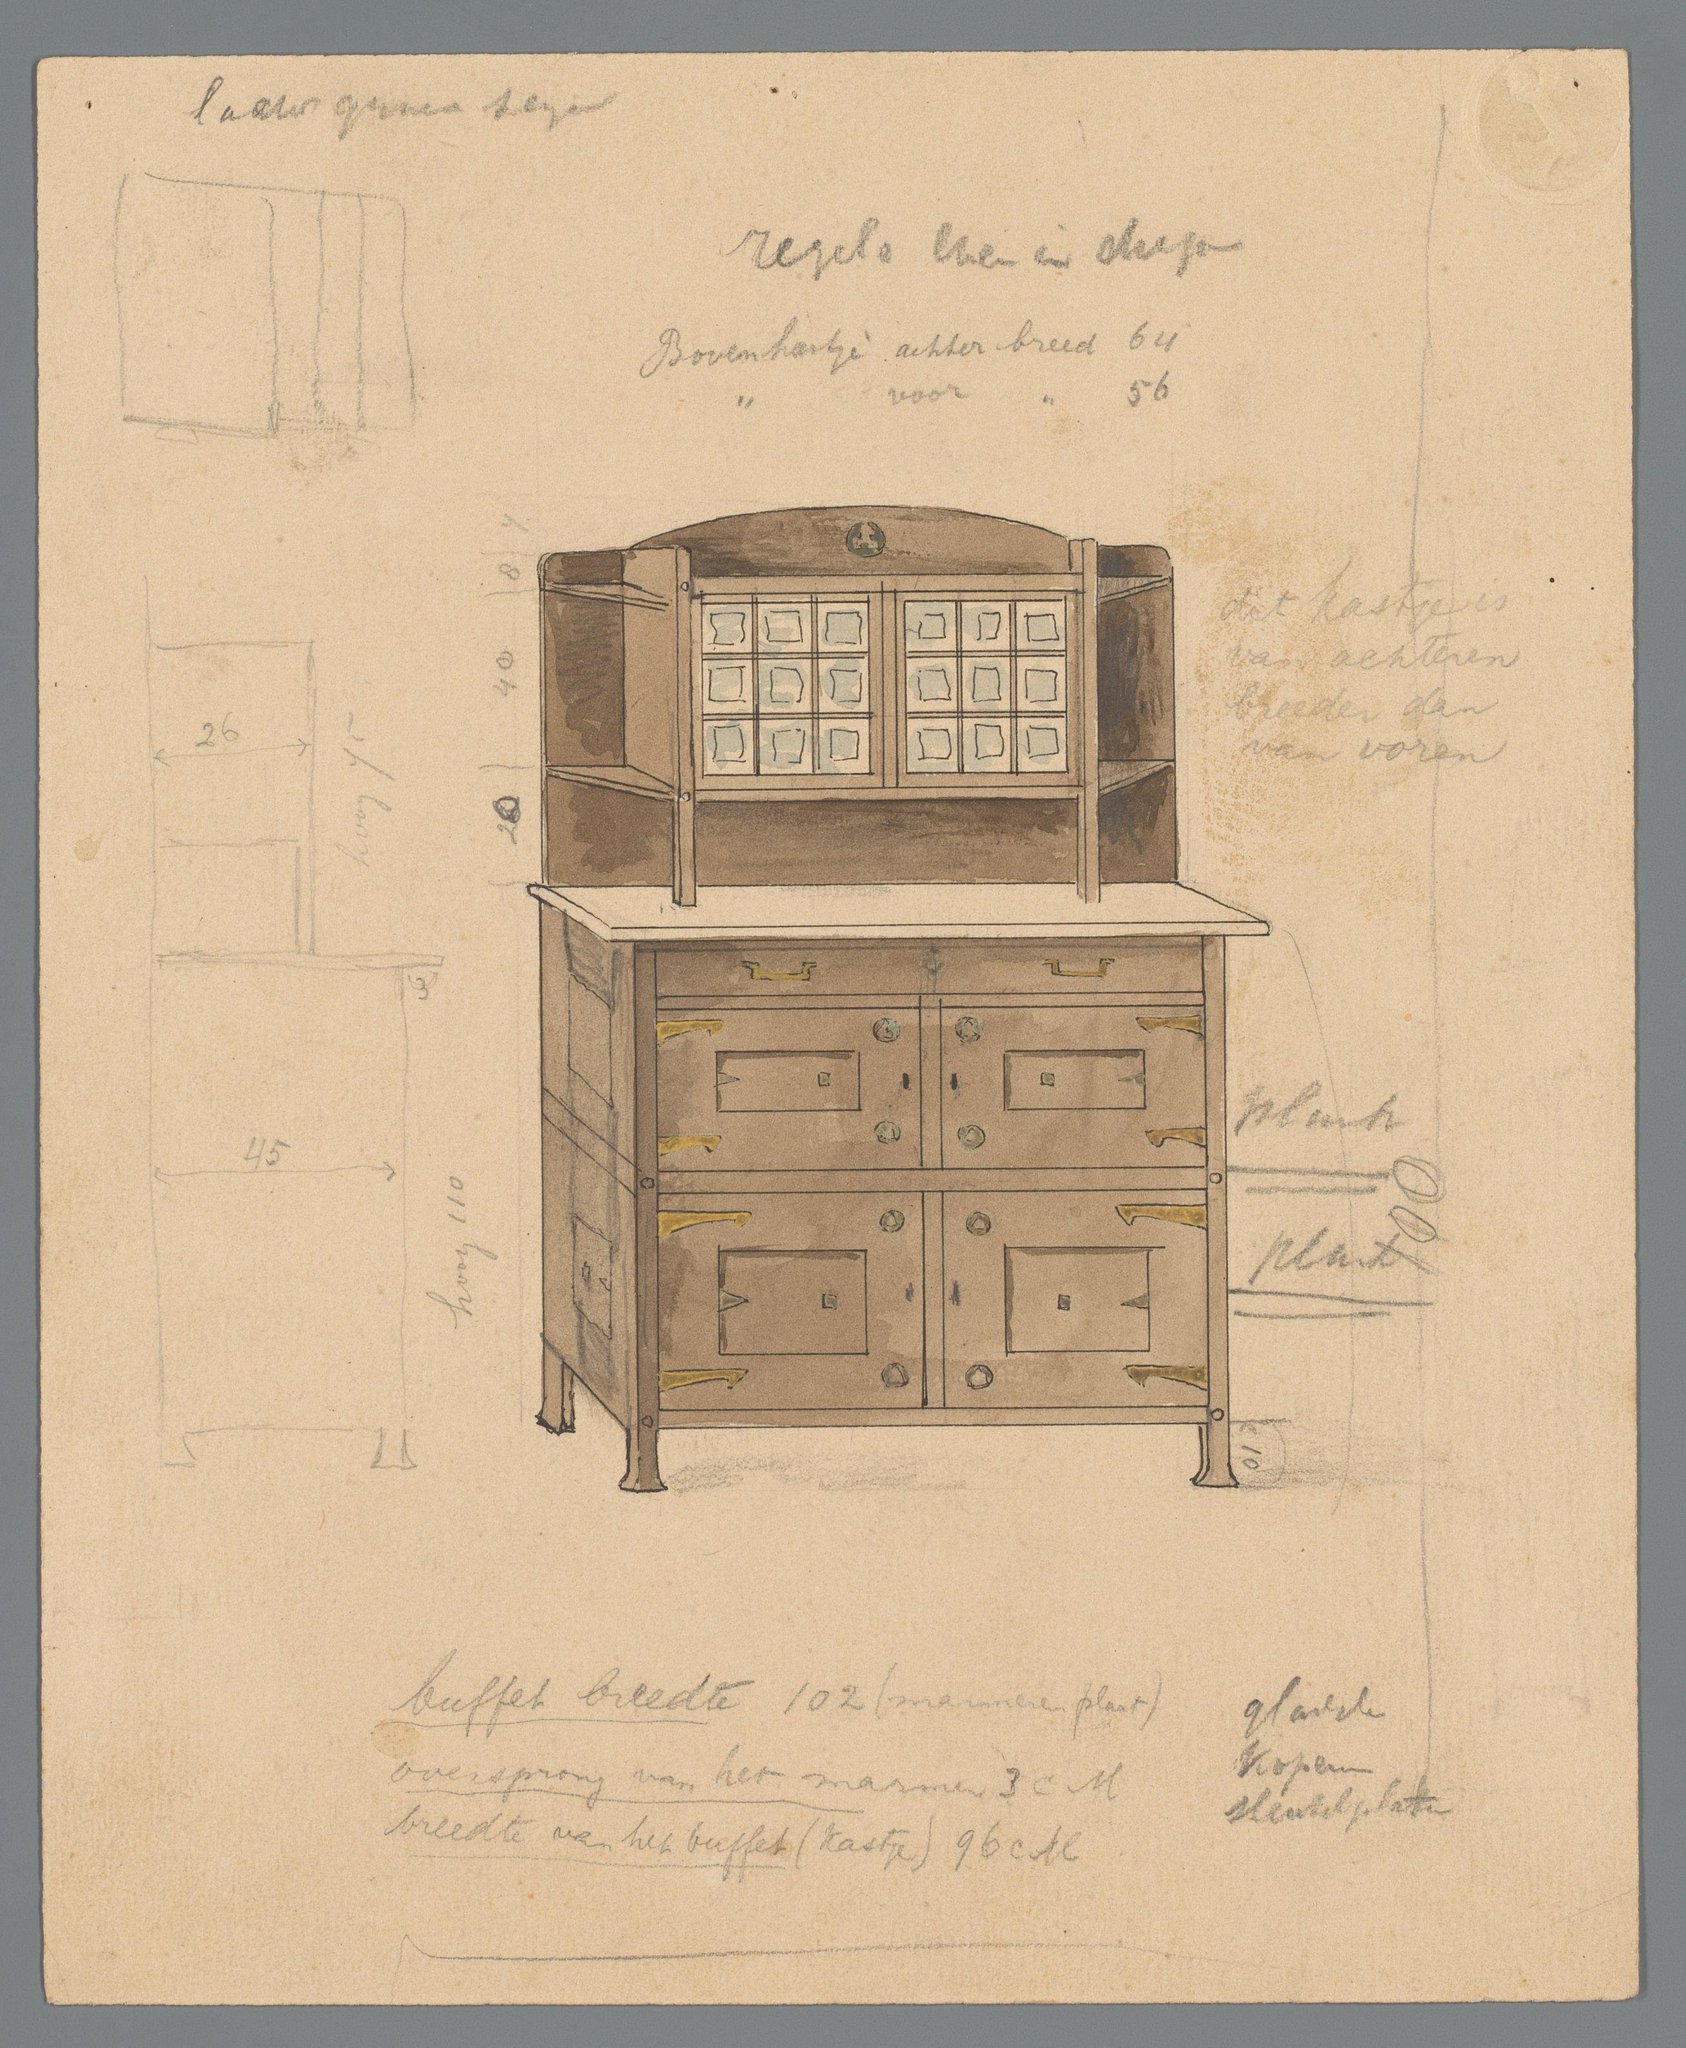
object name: design drawing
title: Ontwerp voor een buffetkast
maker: gust van de wall perné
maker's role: draughtsman, painter, print maker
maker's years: 1877-1911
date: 1887-1911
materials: ink, paper, pencil, watercolor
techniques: brush, pen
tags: ornamental cupboard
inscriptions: stamp:, collector's mark: Lugt 2228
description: Met aantekeningen over de afmetingen en de materialen.